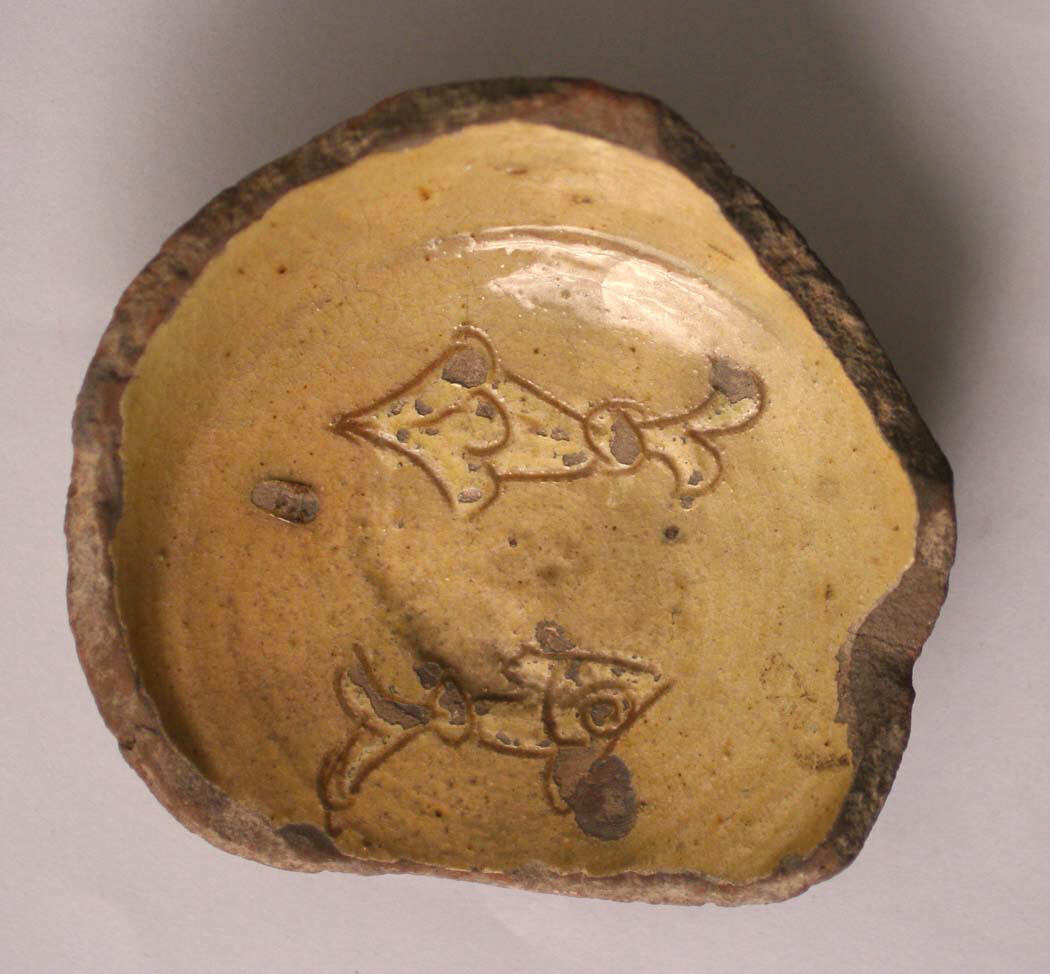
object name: ceramic fragment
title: Fragment of a Cup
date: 1301-1500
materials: earthenware, glaze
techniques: coloring, incising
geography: egypt